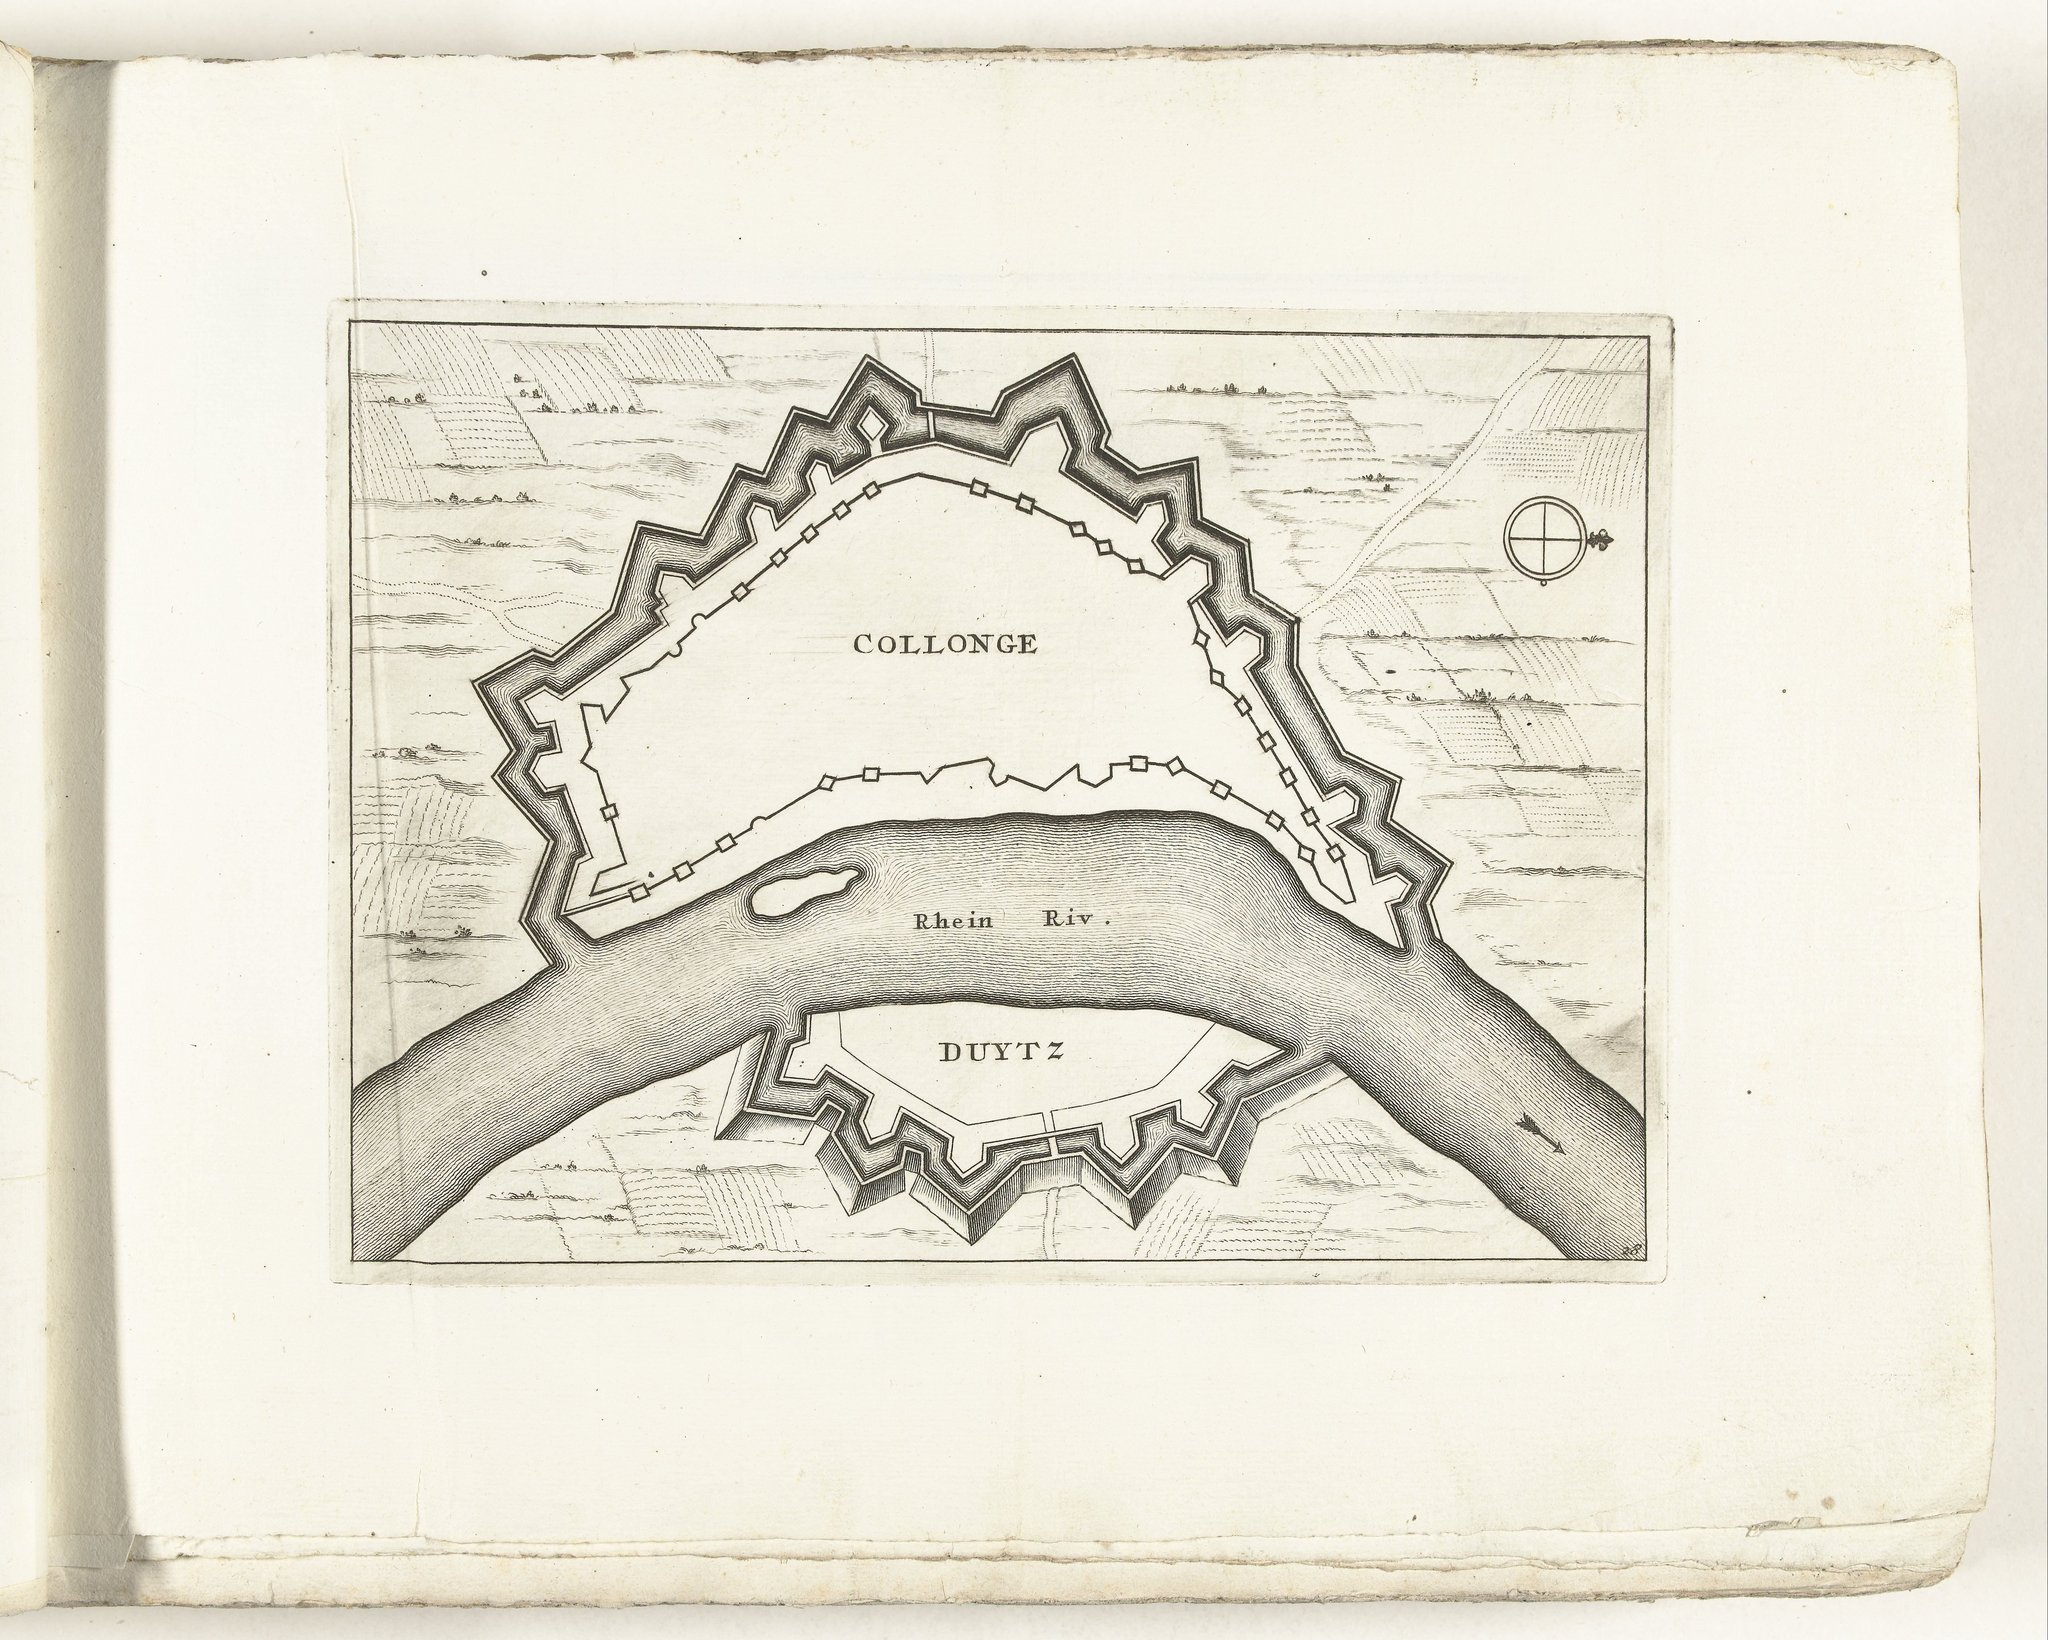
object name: print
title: Plattegrond van Keulen, ca. 1702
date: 1702-1703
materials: paper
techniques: etching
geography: northern netherlands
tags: fortress, maps of cities, cologne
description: Plattegrond van de verdedigingswerken om Keulen. Plaat nr. 28 in het prentwerk bestaande in totaal uit 276 genummerde platen van vermaarde sterke steden en vestingen in het kader van de Spaanse Successieoorlog. Voor het merendeel zijn deze platen gekopieerd naar de anonieme Franse platen: in Les forces de l'Europe en in: Le theatre de la guerre, dans les Pays-Bas, beide oorspronkelijk uitgegeven door Nicolas de Fer te Parijs (1693-1697) in het kader van de Negenjarige Oorlog. Titel en opschriften in het Frans.